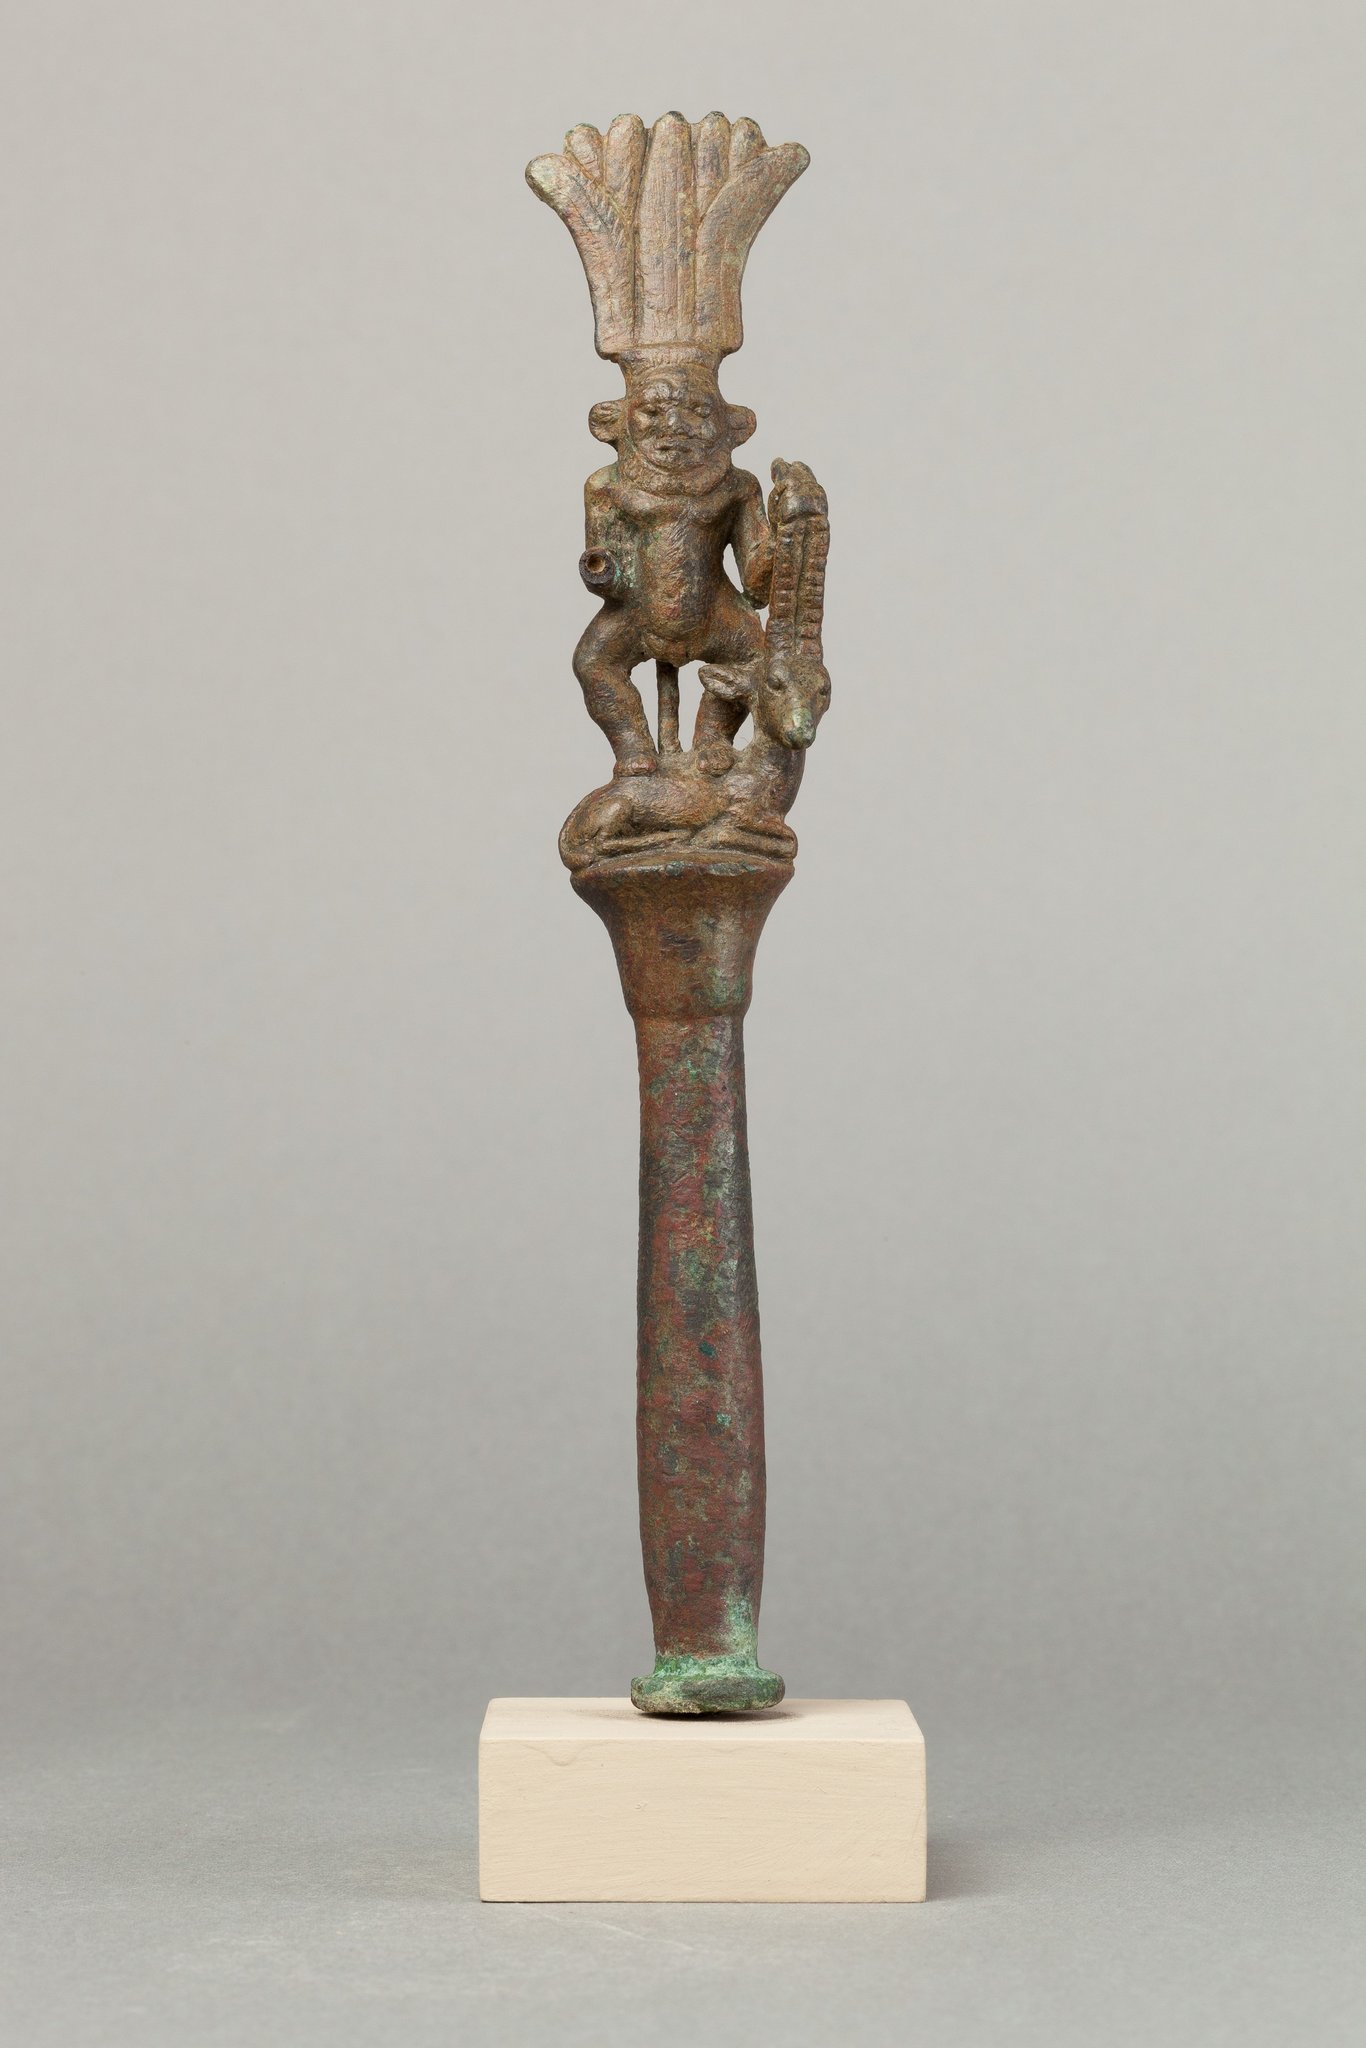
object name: column, be, antelope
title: Papyrus pillar surmounted by Bes with an antelope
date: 664-630 BCE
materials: metal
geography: egypt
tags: animals,bes